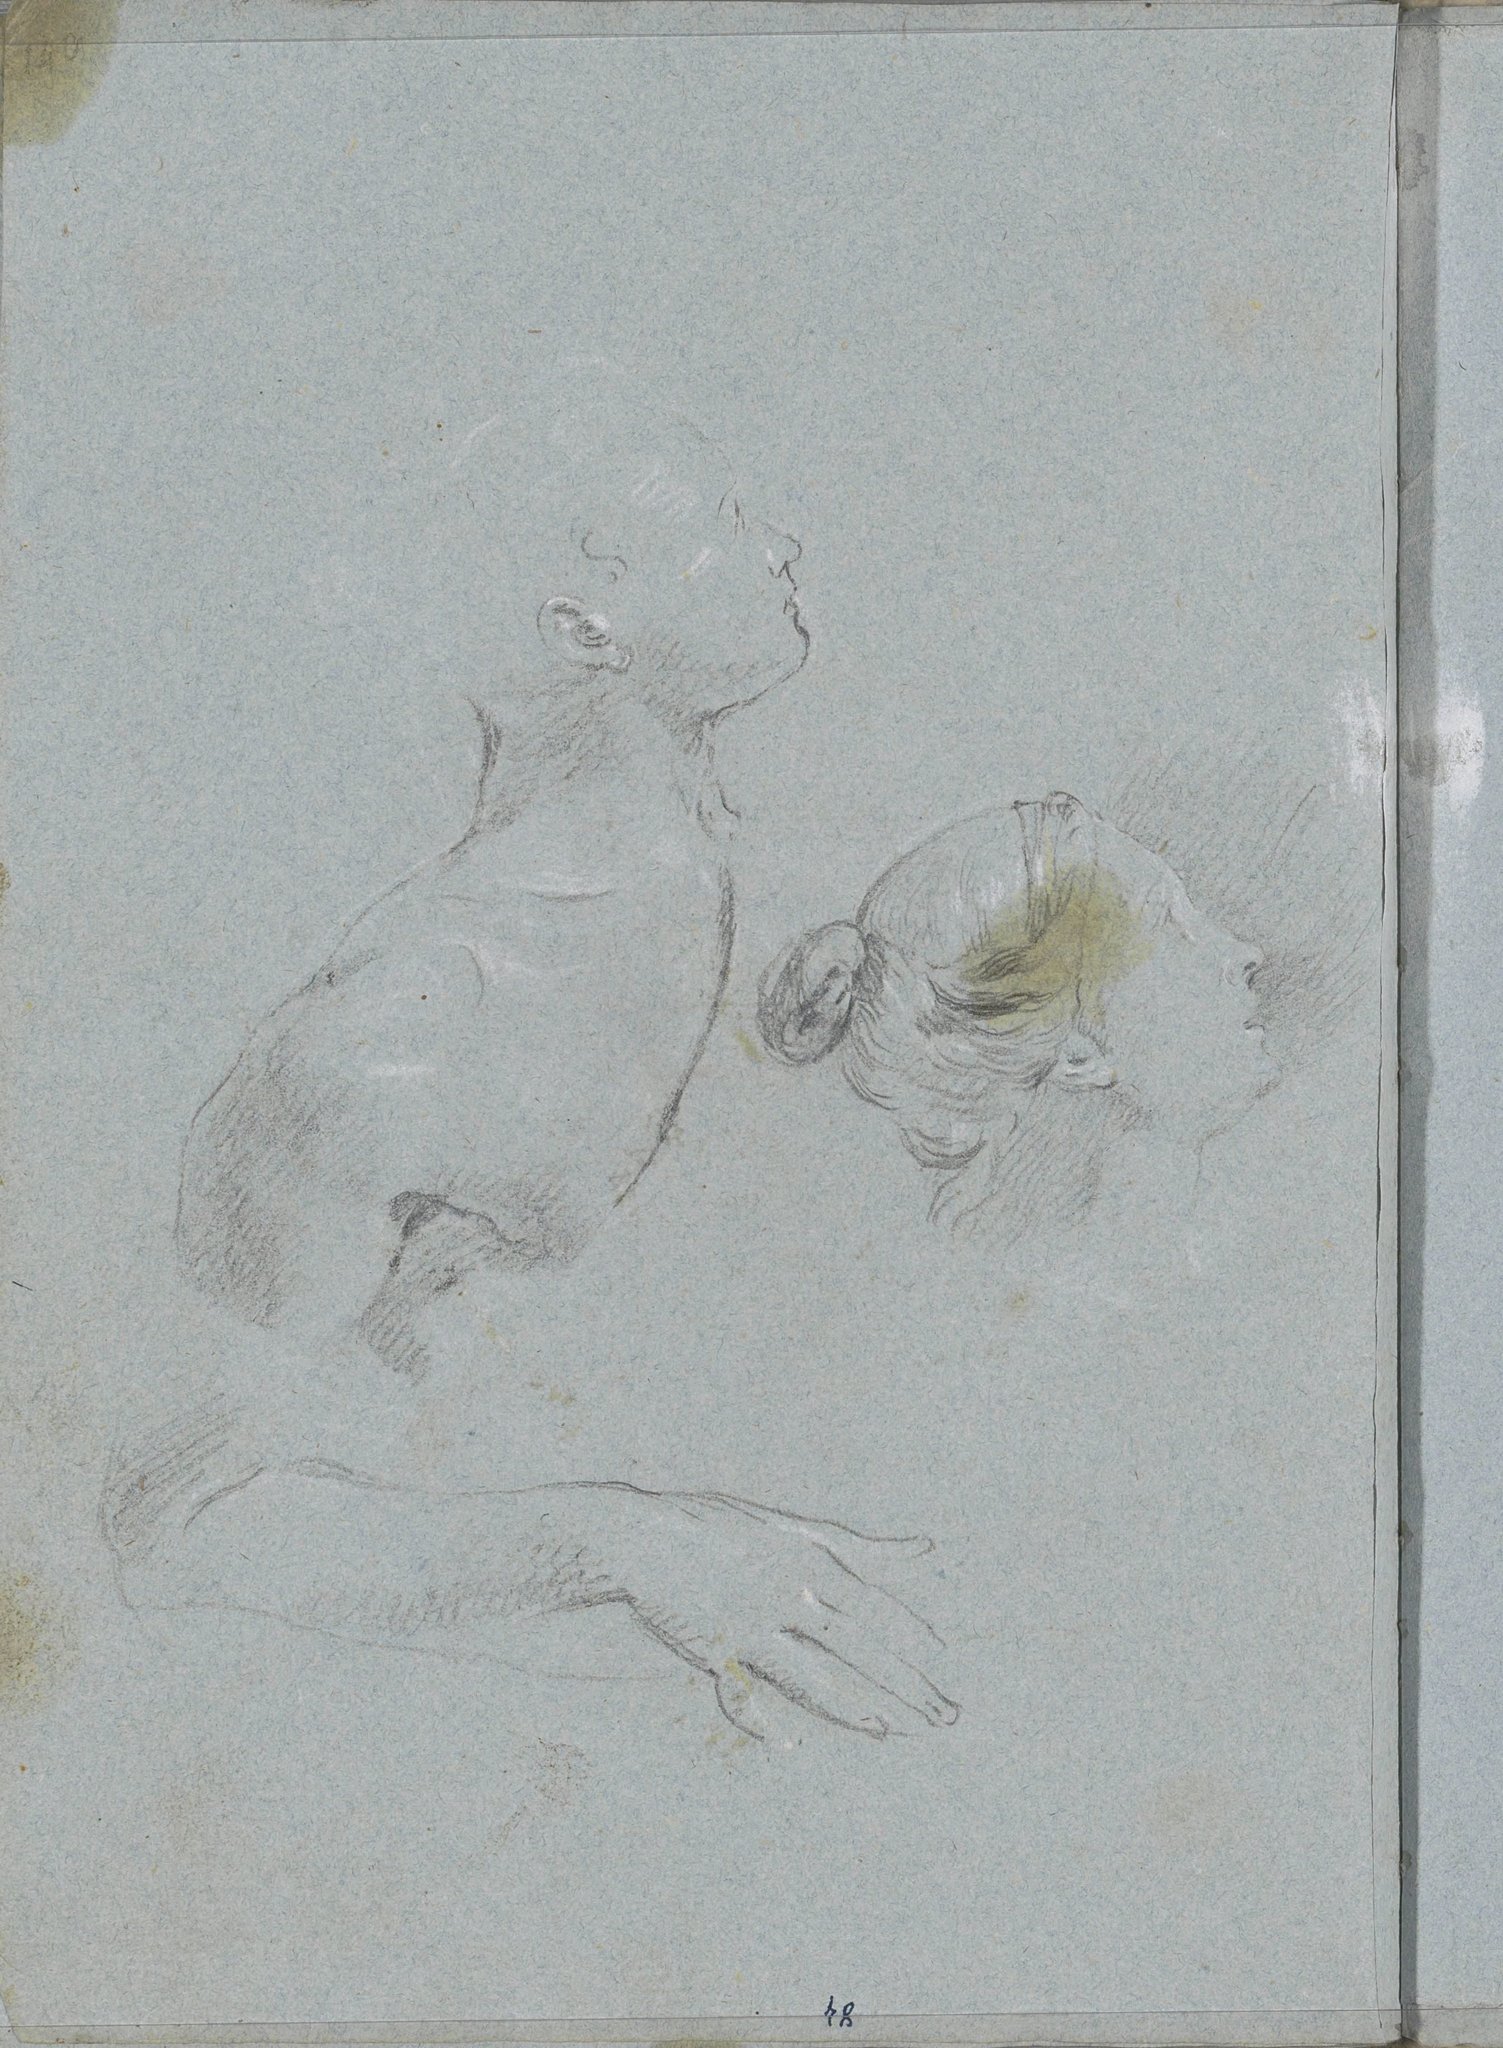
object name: sketchbook leaf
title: Schouder en arm en een kop van een vrouw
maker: lorenzo baldissera tiepolo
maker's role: draughtsman, print maker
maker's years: 1736-1776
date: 1751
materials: chalk, paper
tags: arms, shoulder, head (human) - aa - female human figure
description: Bladzijde 140 uit een schetsboek met 158 bladzijden.